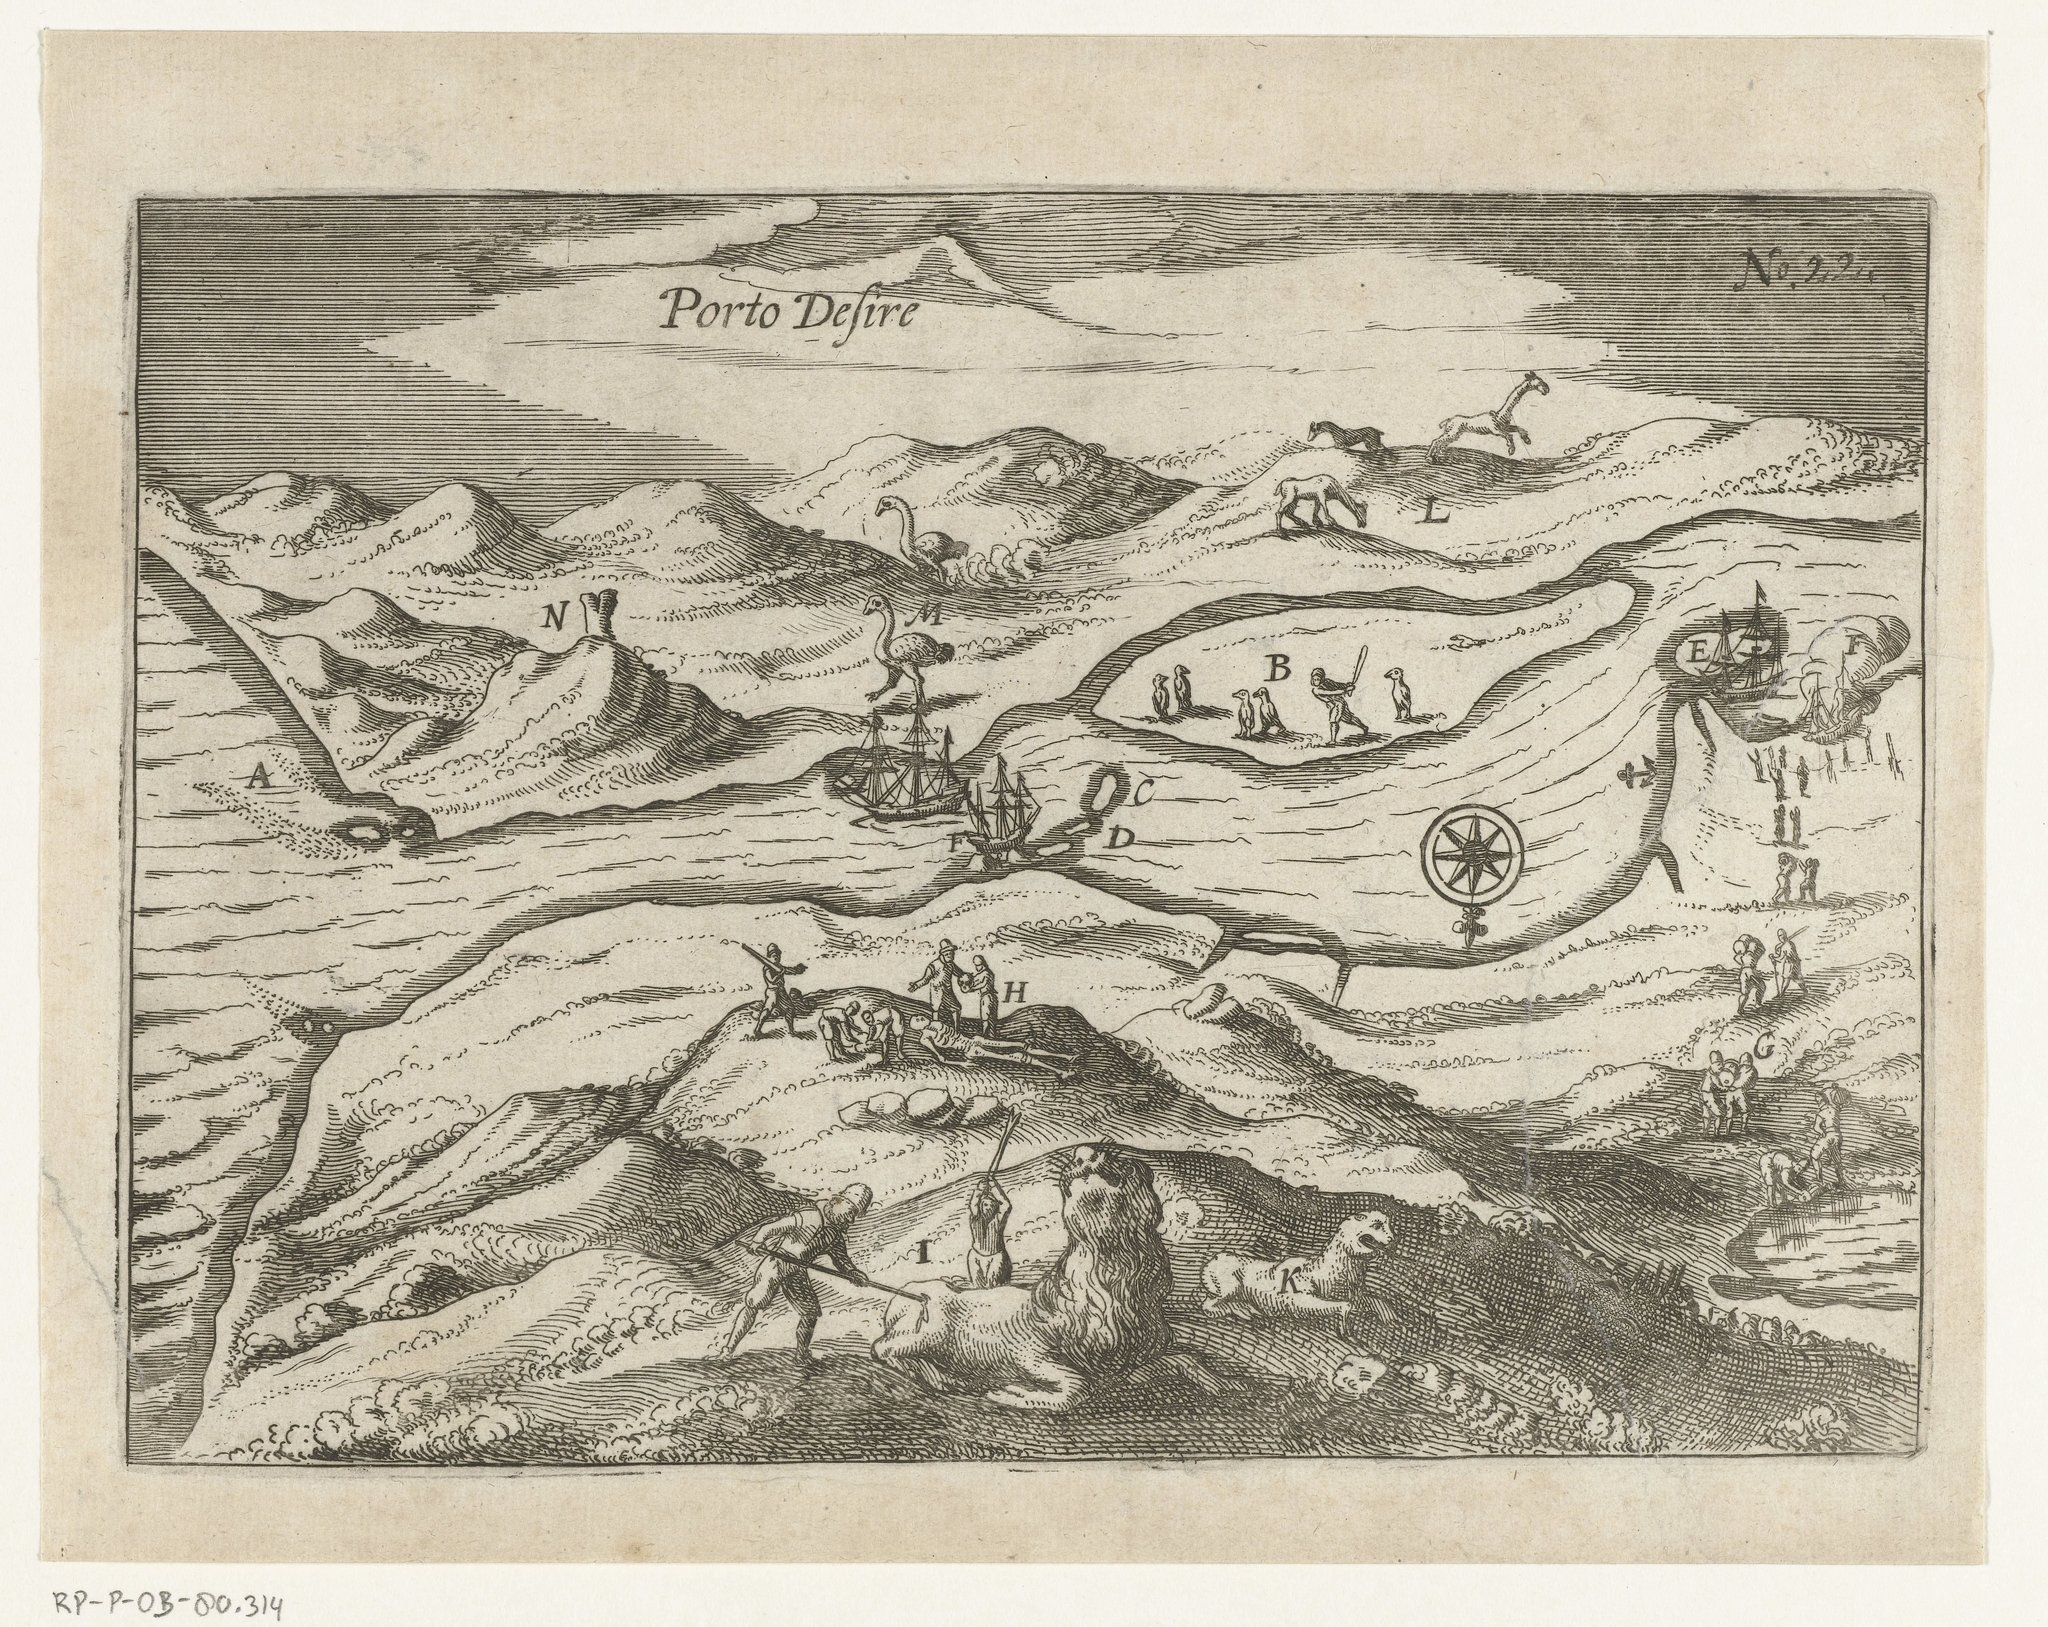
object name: print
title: Afbeeldinghe van Porto Desire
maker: Anonymous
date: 1617-1619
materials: paper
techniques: etching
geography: northern netherlands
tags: hoorn (north holland), hunting, chase, landscapes in polar regions, exploration, expedition, voyage of discovery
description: Oorspronkelijke illustraties eerst gebruikt in: Willem Cornelisz Schouten, Iovrnael ofte beschryvinghe van de wonderlijcke reyse, ghedaen door Willem Cornelisz Schouten van Hoorn, inde iaren 1615. 1616. en 1617, Willem Jansz Blaeu, Amsterdam, 1618. Kopieën naar deze platen gebruikt in: J. van Spilbergen, Oost ende West-Indische spiegel der 2 leste navigatiën, ghedaen inden jaeren 1614, 15, 16, 17, ende 18. daer in vertoont woort, in wat gestalt Ioris van Speilbergen door de Magellanes de werelt rontom geseylt heeft ...; met de Australische navigatiën, van Iacob le Maire, ... met veel wonders ... in 26 coperen platen afghebeelt, N. Geelkerck, Leiden 1619. Later opnieuw gebruikt in : I. Commelin, Begin ende voortgangh, van de Vereenighde Nederlantsche Geoctroyeerde Oost-Indische Compagnie, J. Janssonius, Amsterdam 1646. Genummerd: No. 22.